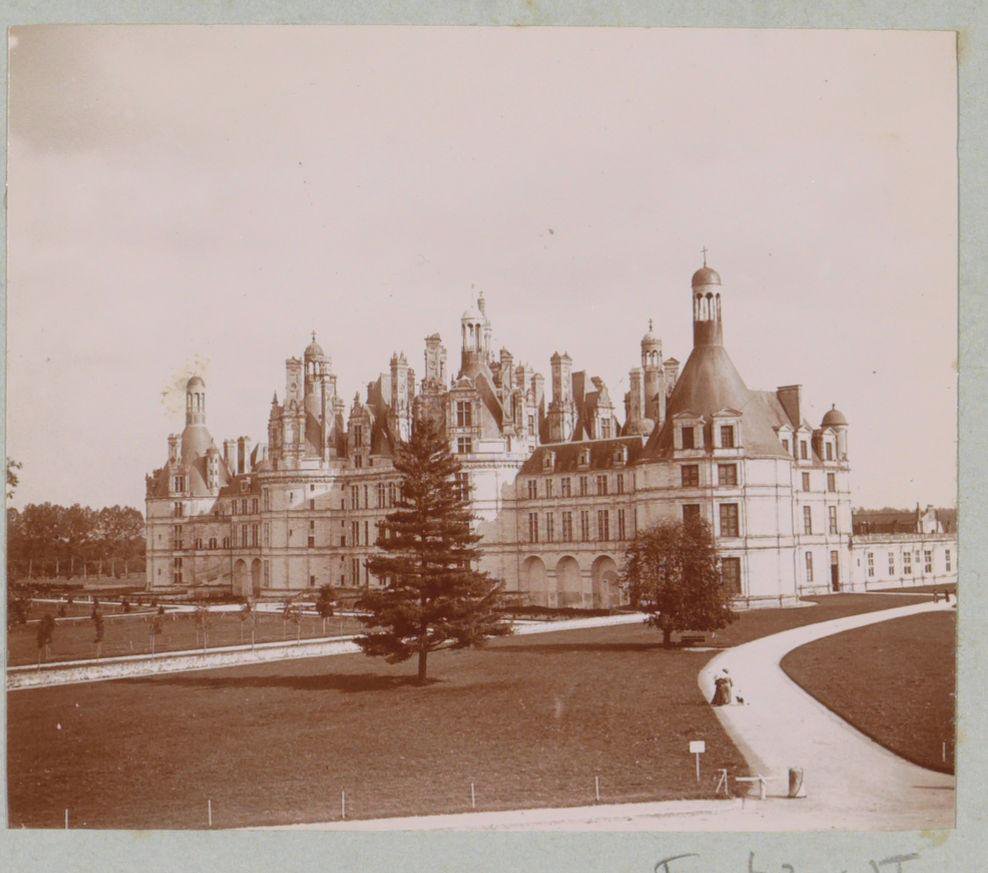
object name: photograph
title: Gezicht op het kasteel van Chambord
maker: delizy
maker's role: manufacturer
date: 1904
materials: paper, photographic support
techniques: gelatin silver print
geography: chambord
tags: castle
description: Onderdeel van Fotoalbum van een Franse amateurfotograaf met opnames van uitstapjes in Frankrijk, Spanje, België, Luxemburg en Nederland, de eerste automobielen en autoraces.